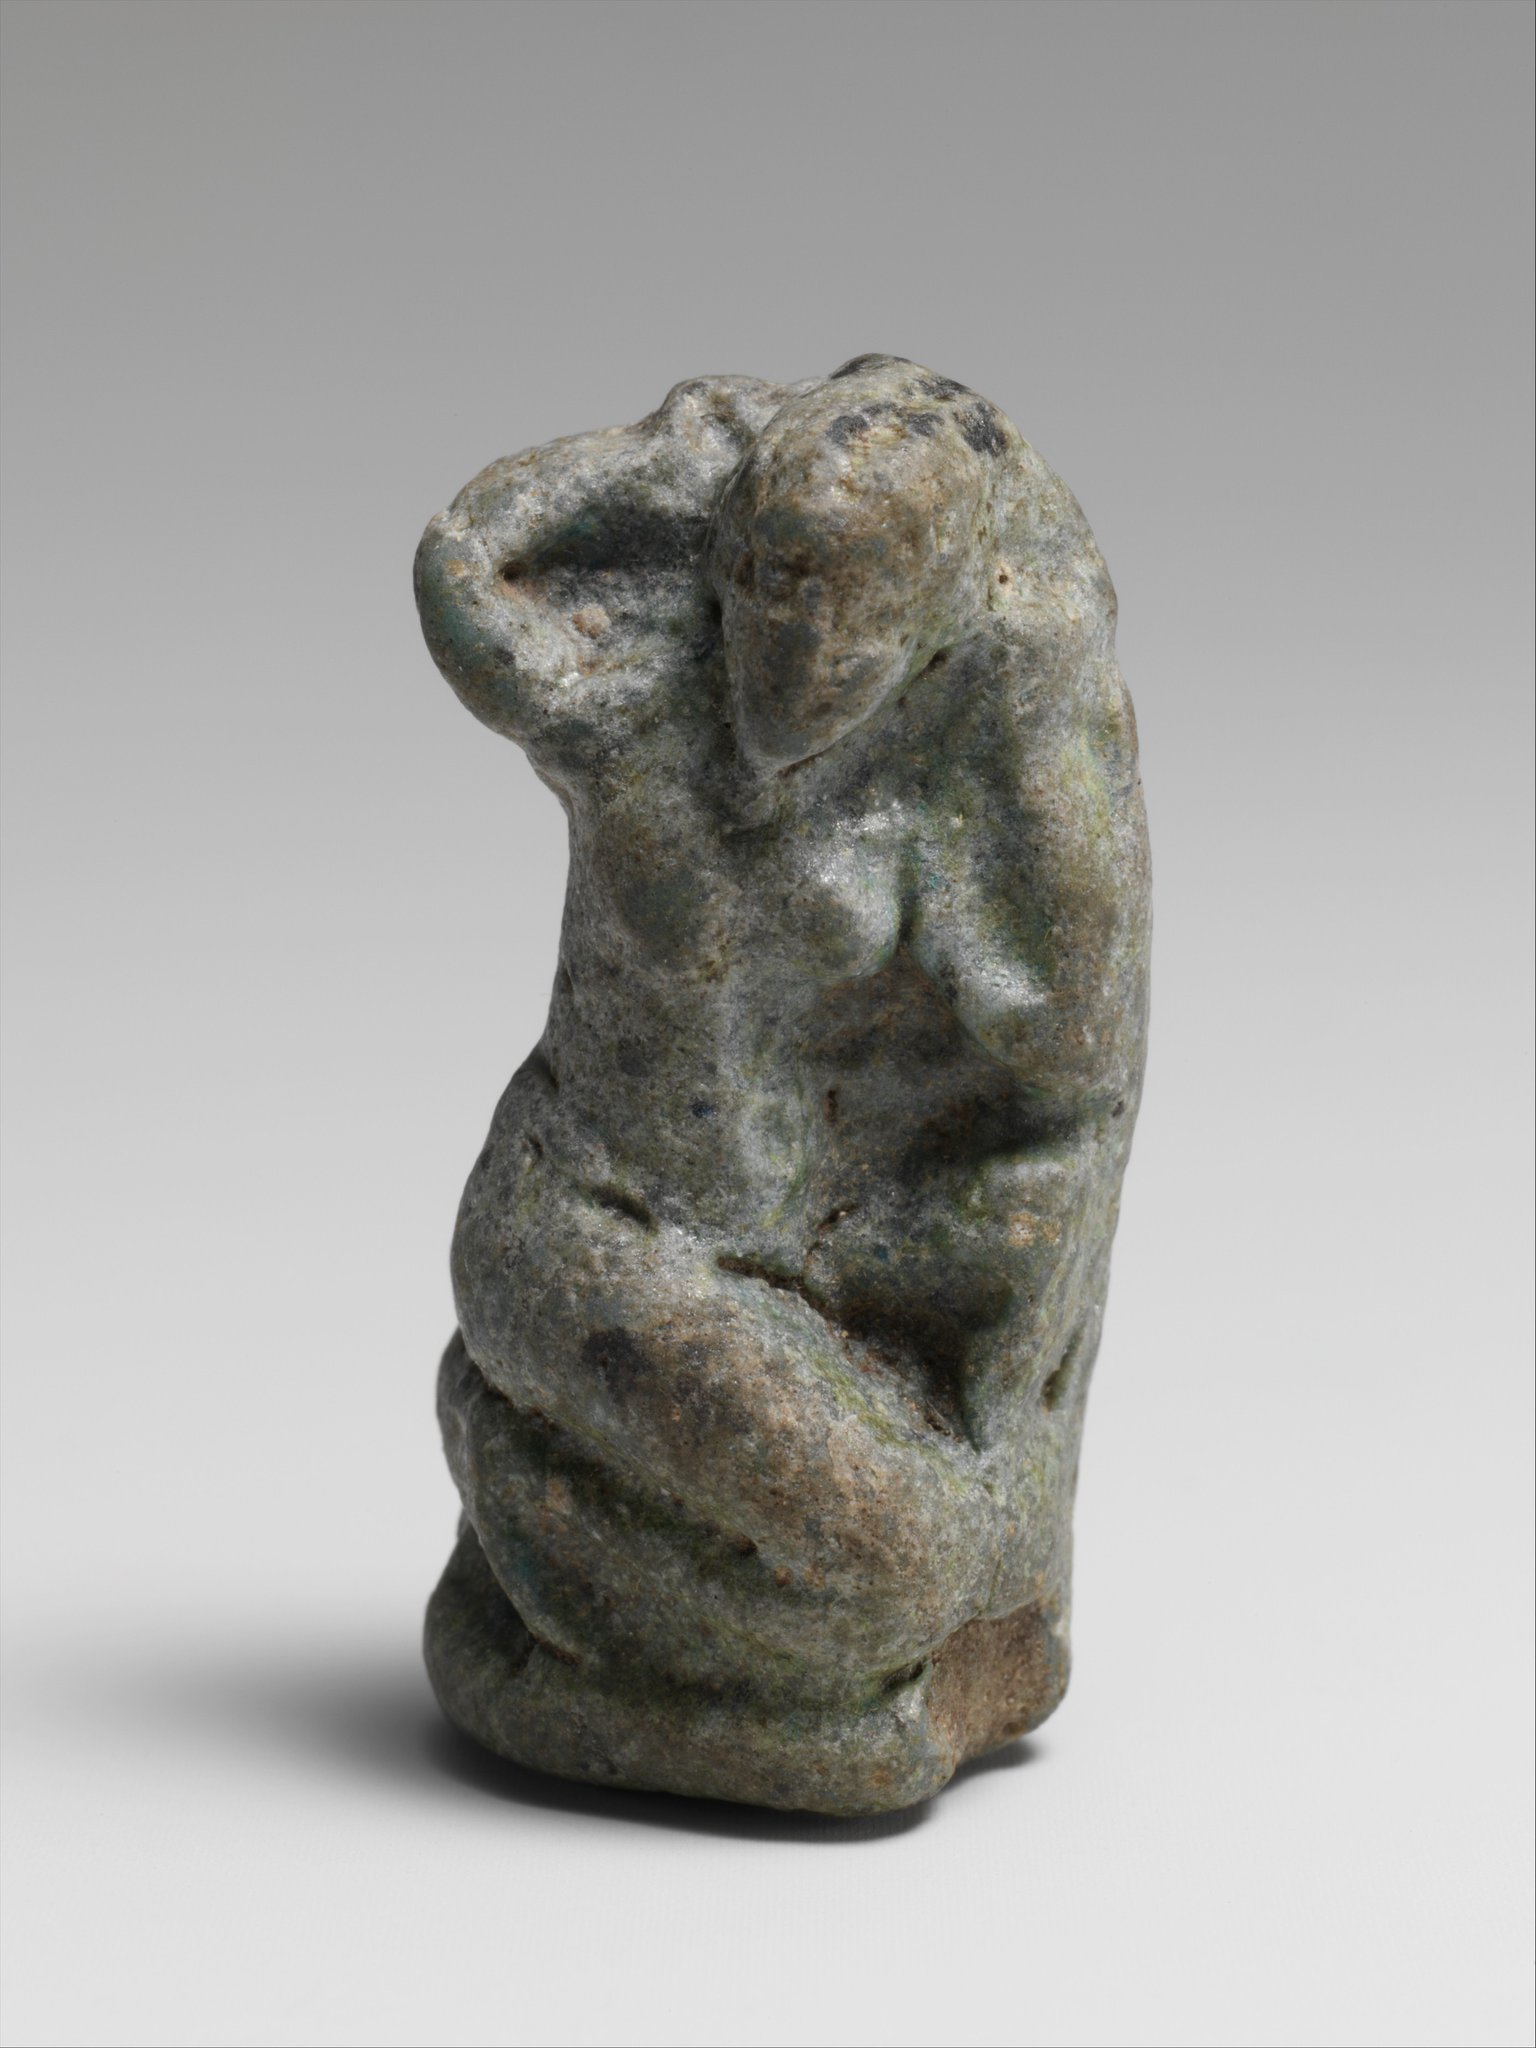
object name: amulet, aphrodite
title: Faience statuette of Aphrodite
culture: egyptian, ptolemaic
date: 334-330 BCE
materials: faience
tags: aphrodite